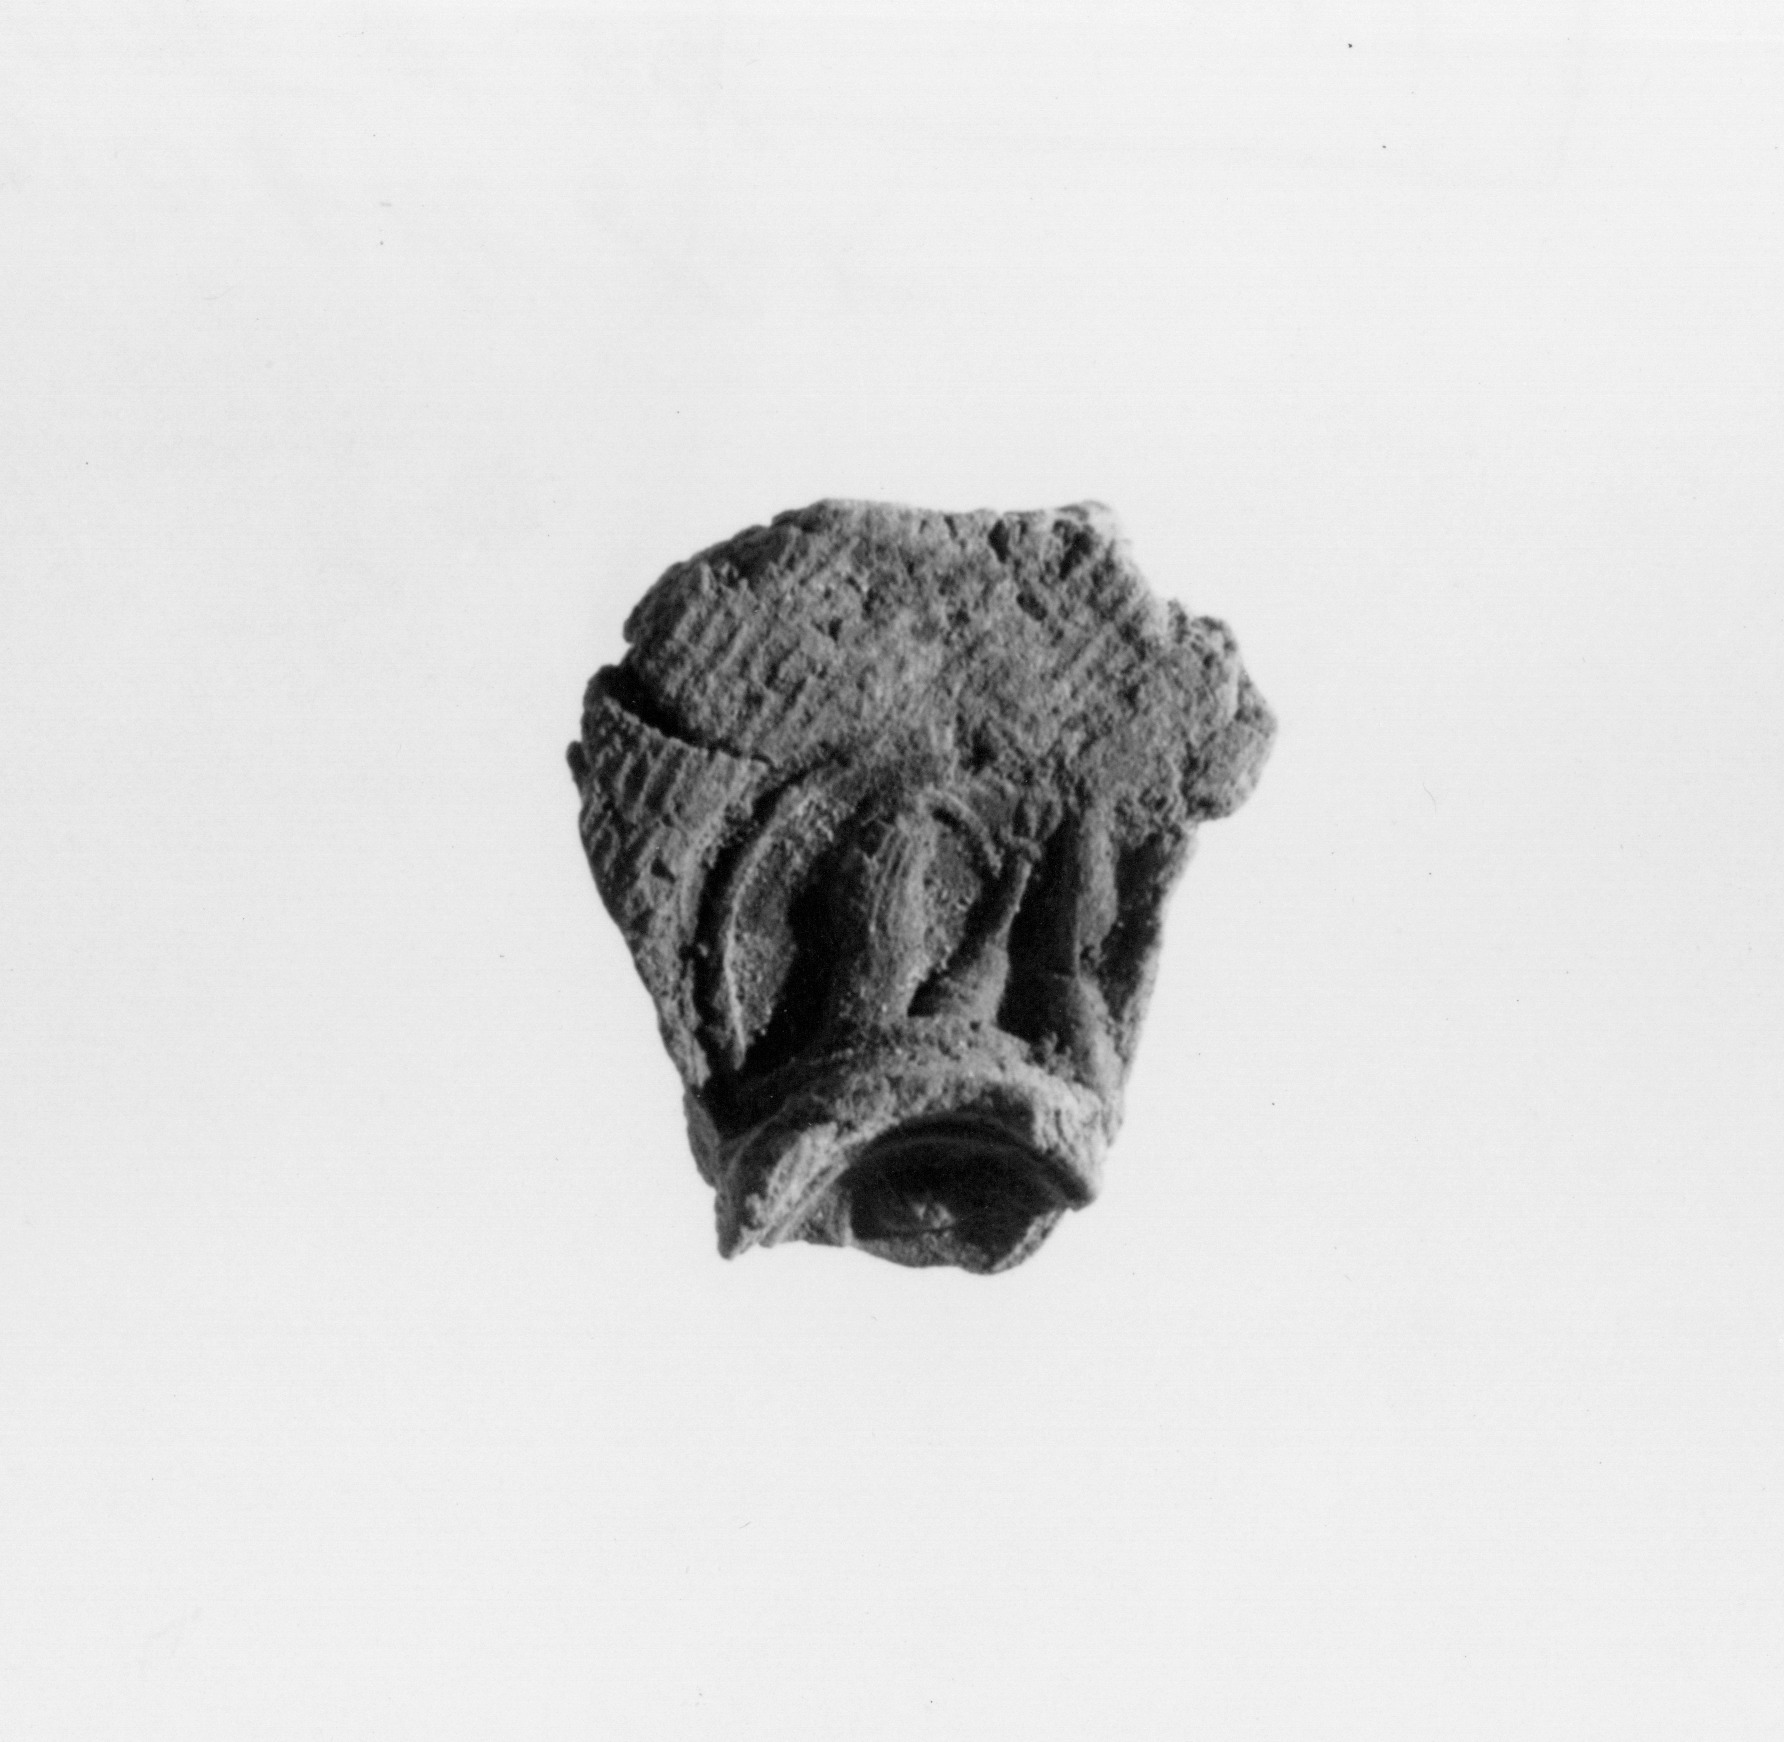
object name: sealing, nebmaatre, amenhotep iii, thoth, double crown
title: Document Sealing With the Throne Name of Amenhotep III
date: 1390-1352 BCE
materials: mud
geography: egypt